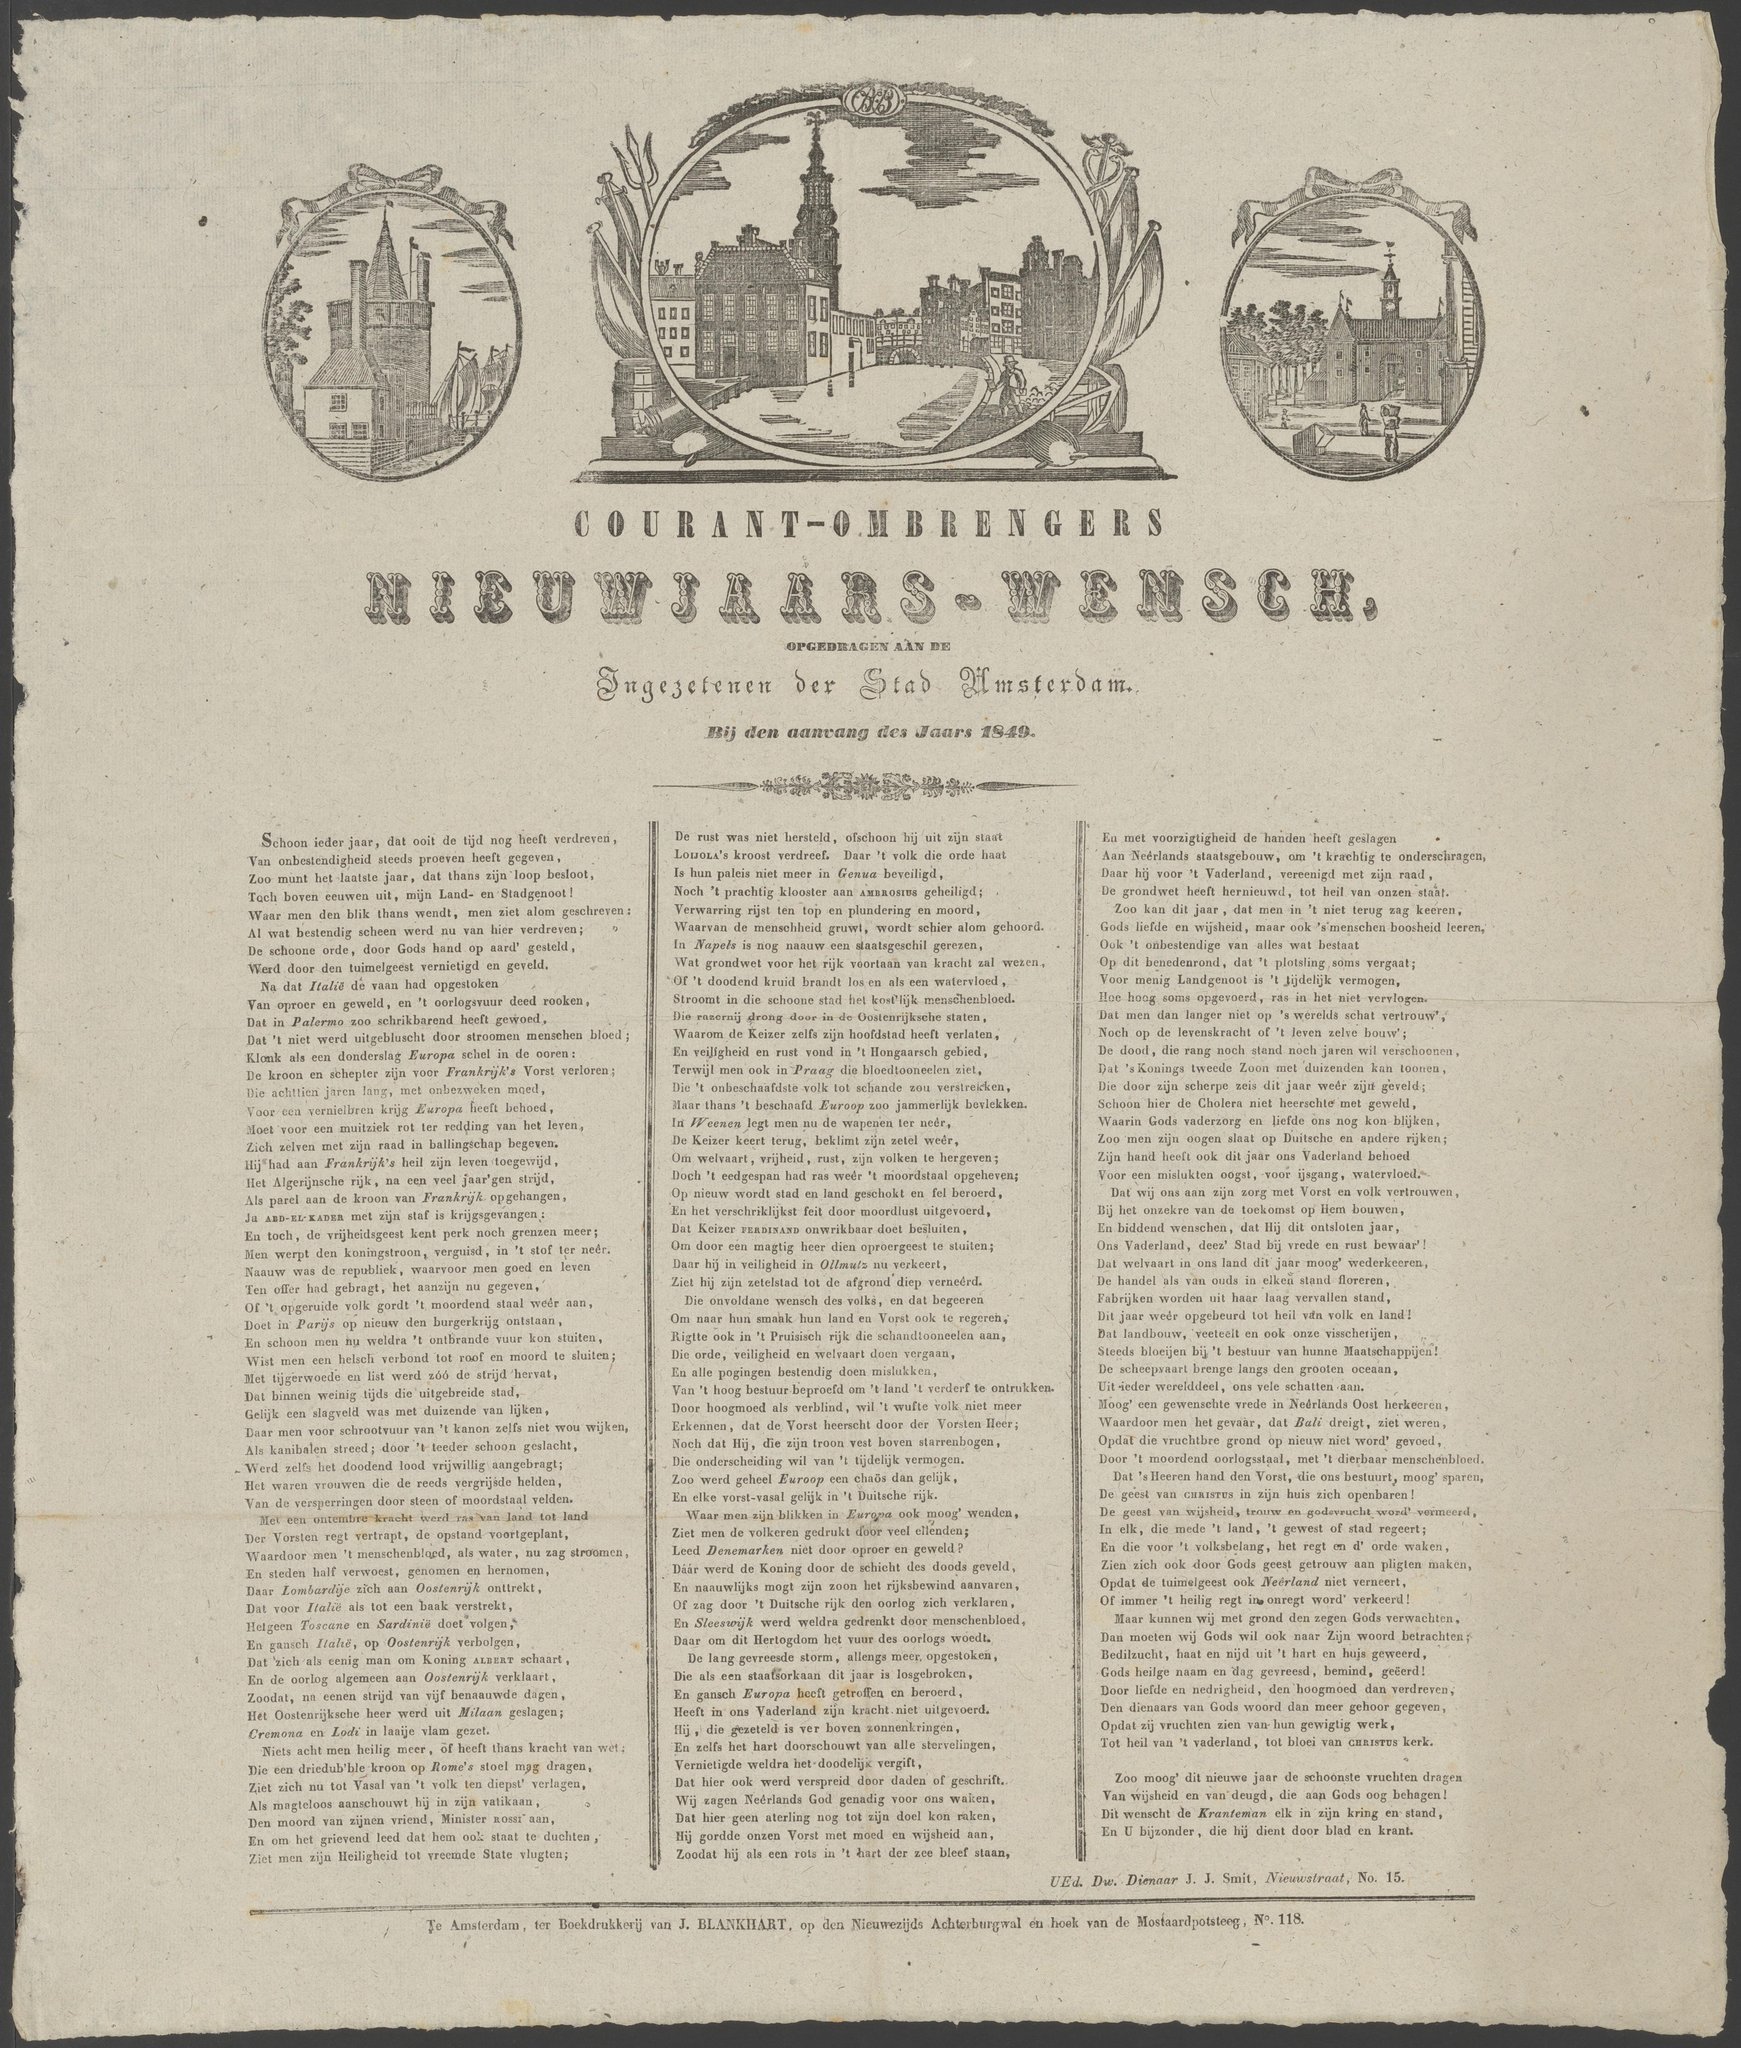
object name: print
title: Nieuwjaarwens van de courant-ombrengers van de stad Amsterdam, voor het jaar 1849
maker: Anonymous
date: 1848-1849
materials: paper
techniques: letterpress printing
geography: amsterdam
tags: delivery (of newspaper), street, amsterdam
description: Nieuwjaarswens namens de ombrengers van couranten (krantenbezorgers) te Amsterdam voor het jaar 1849. Bovenaan drie medaillons met centraal een gezicht op het Singel bij de Munt met op de kade een krantenbezorger, links de Schreierstoren, rechts de Leidsepoort. Onderaan een gedicht in drie kolommen. Van de courantombrenger: J.J. Smit. Onderwerpsrubrieken binnen de Atlas Zeden en Gewoonten: Zeden en gewoonten in engeren zin, Volksleven, Volksbladen, Nieuwjaars- en Kerstwenschen, Amsterdam.